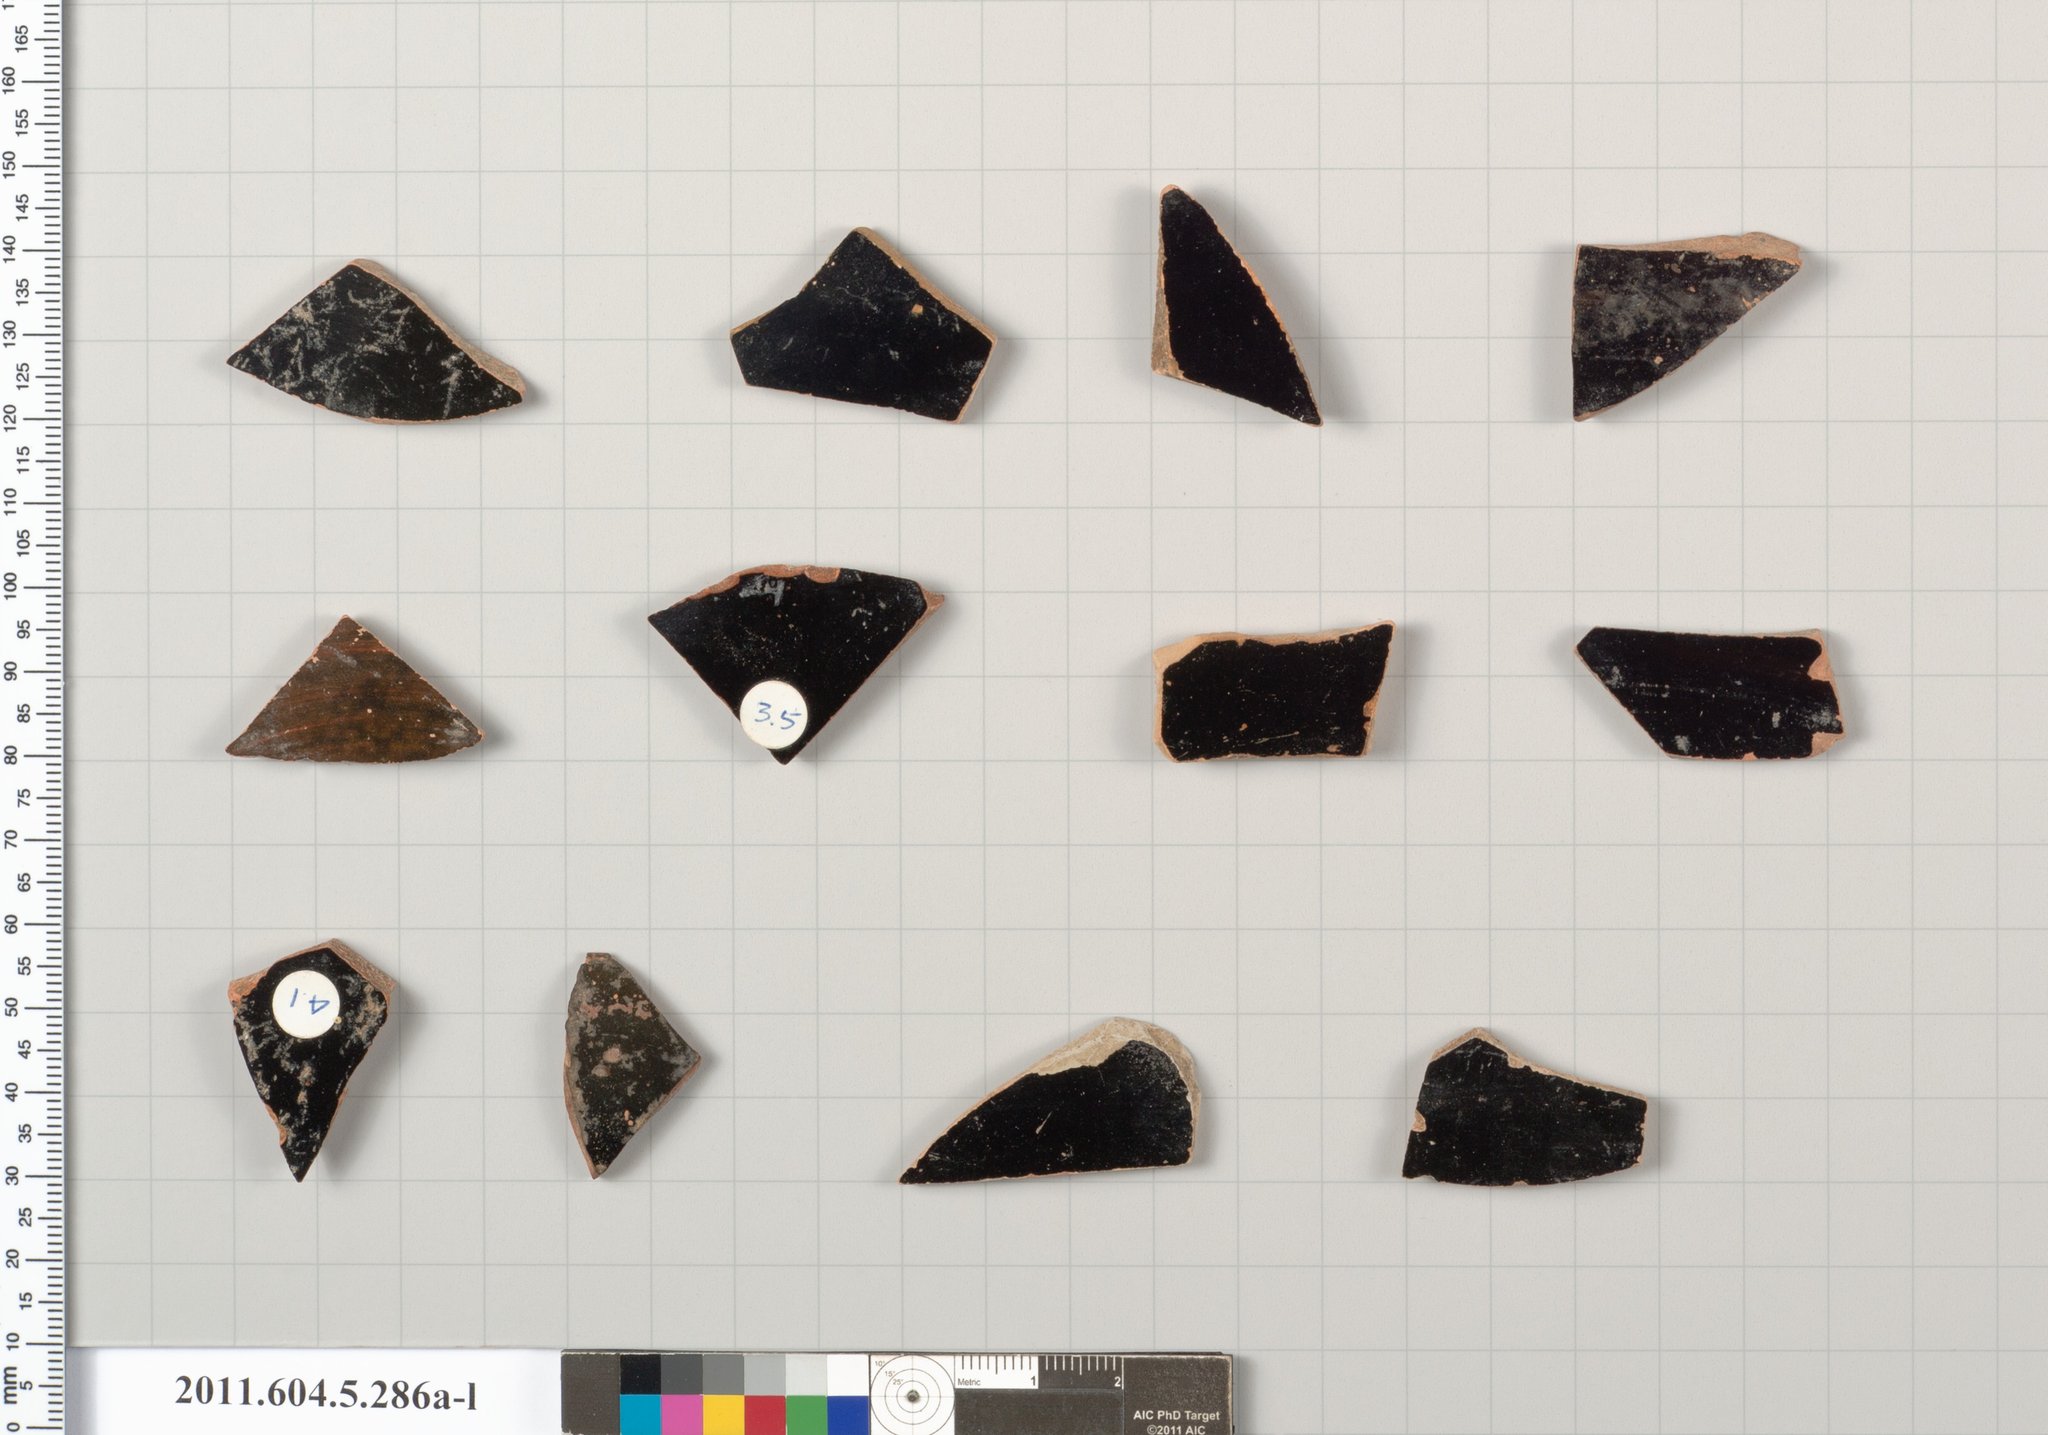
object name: kylix fragment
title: Terracotta fragments of kylikes (drinking cups)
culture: greek, attic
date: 600-401 BCE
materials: terracotta